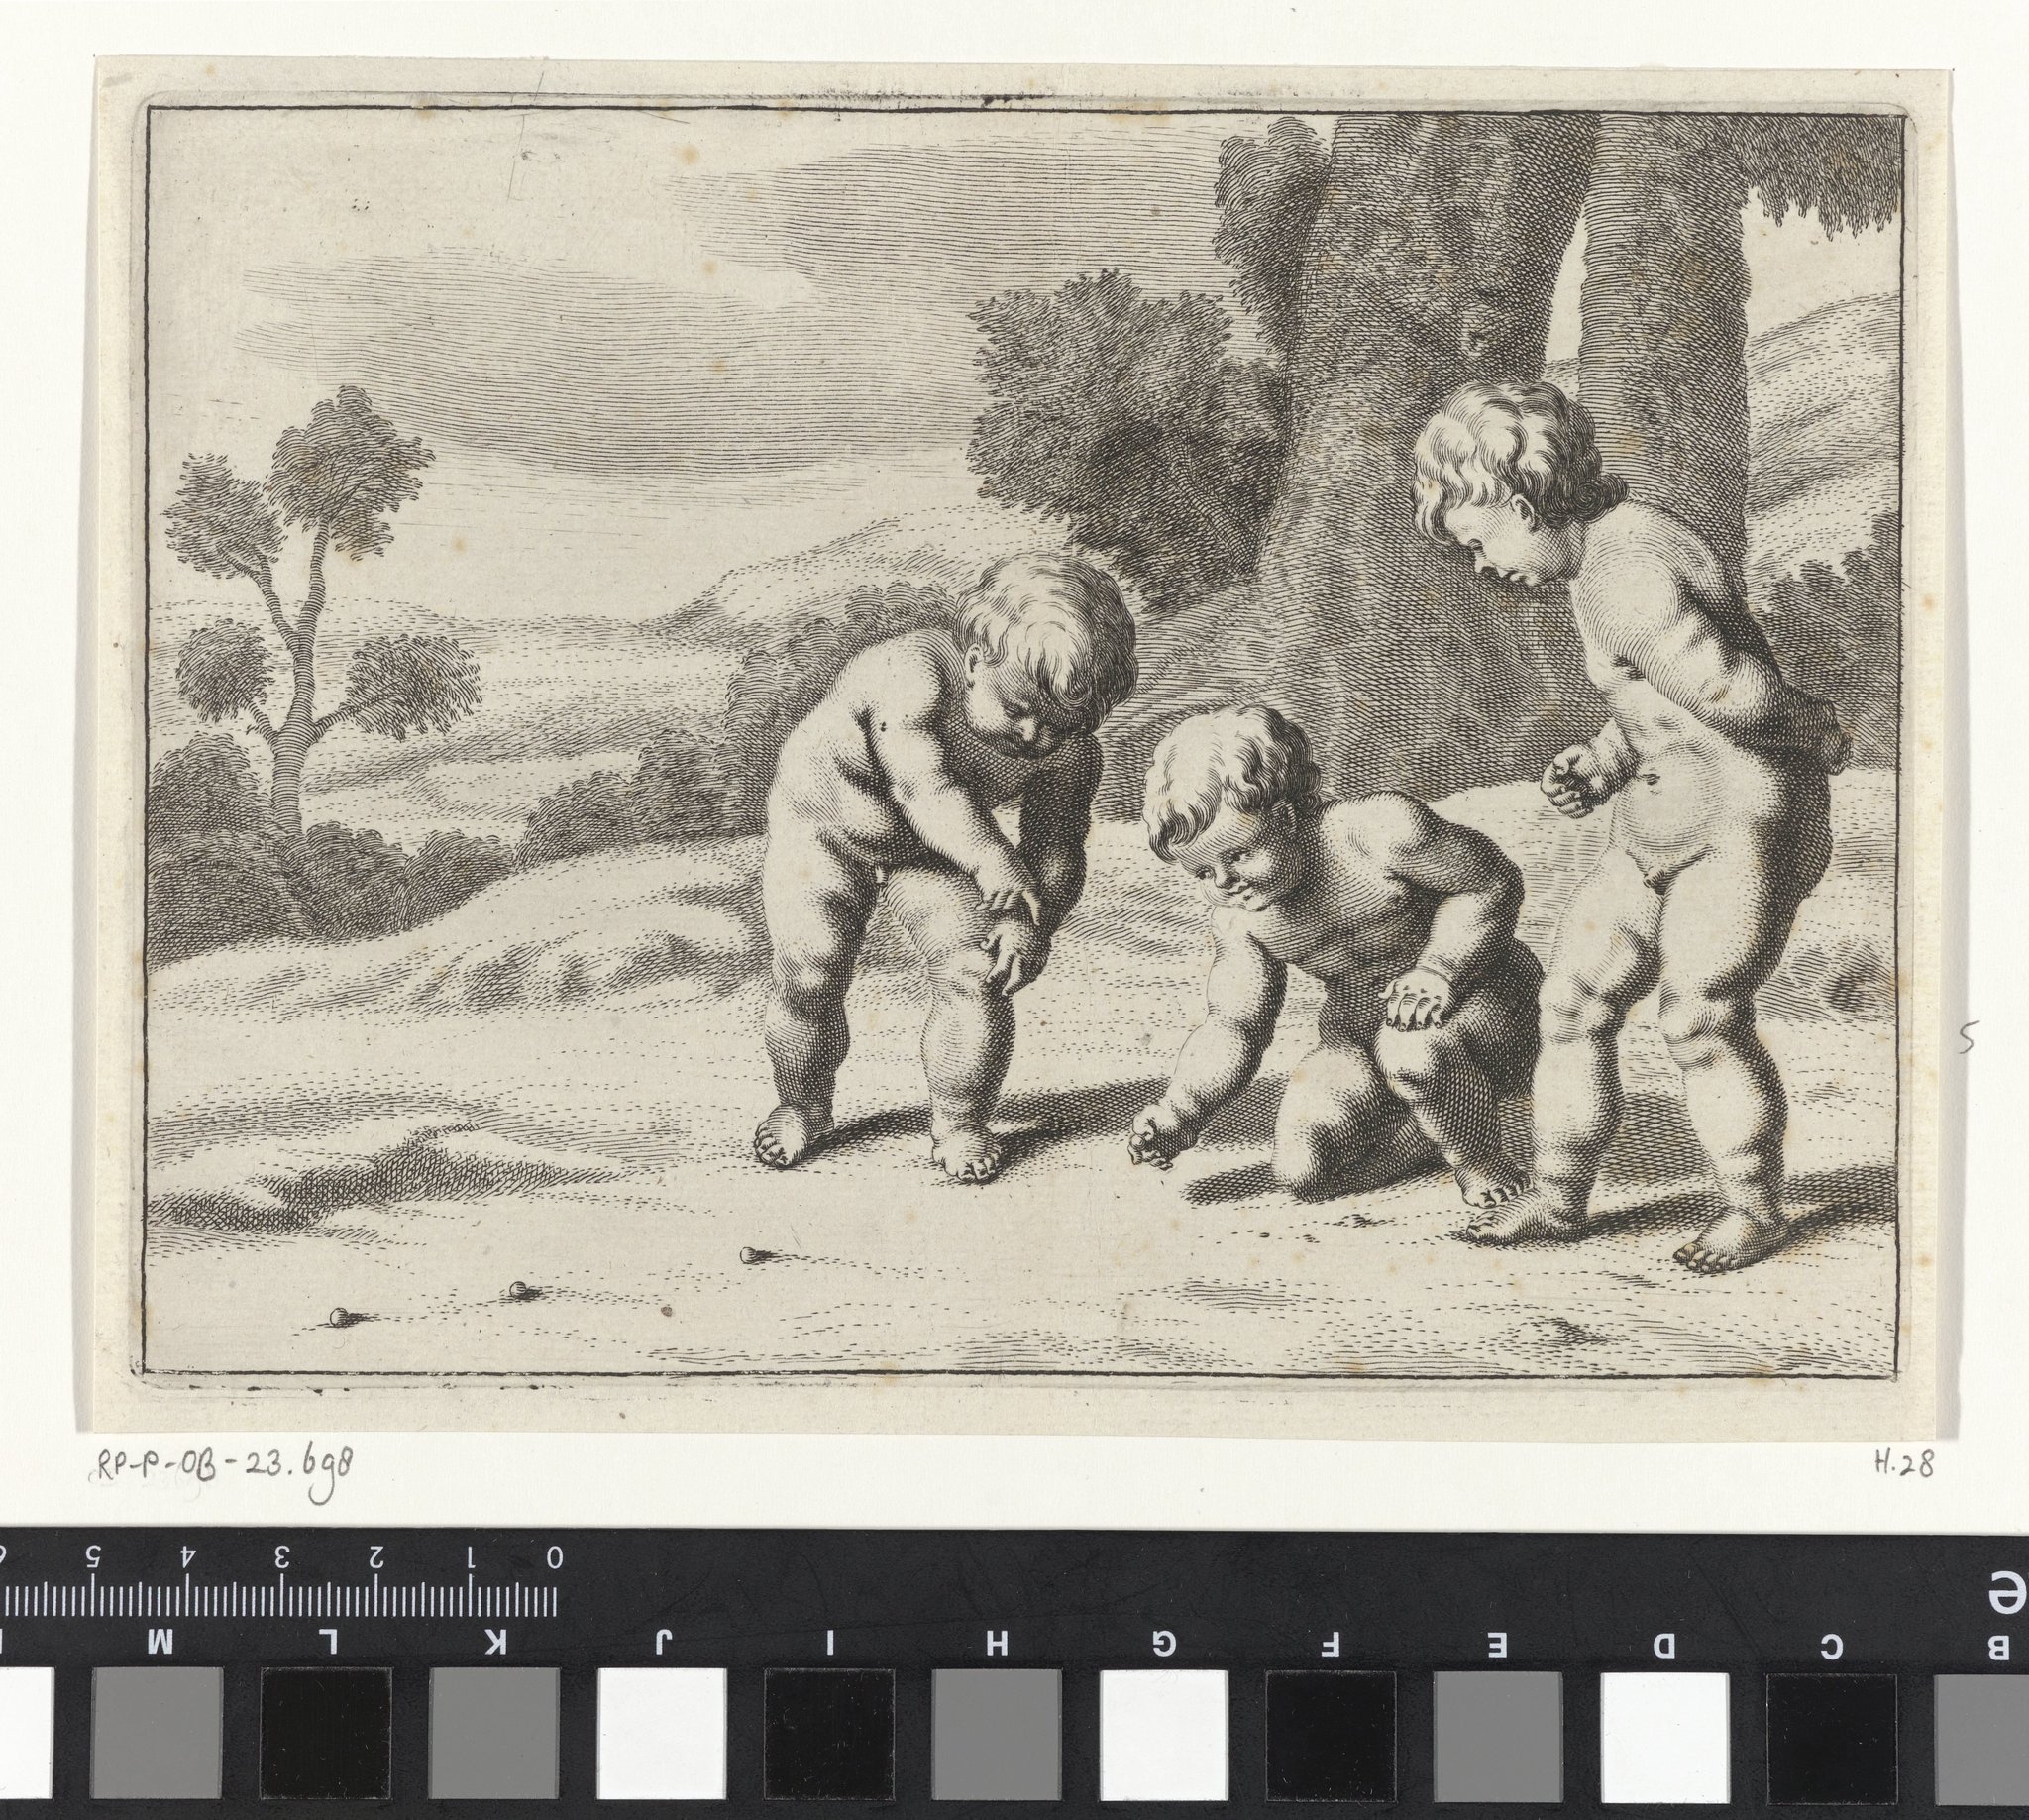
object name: print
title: Spelende kinderen (serie B)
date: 1640-1655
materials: paper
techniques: engraving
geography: amsterdam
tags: (playing at) marbles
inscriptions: collector's mark: Lugt 2228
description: Drie kinderen spelen in een landschap met knikkers.